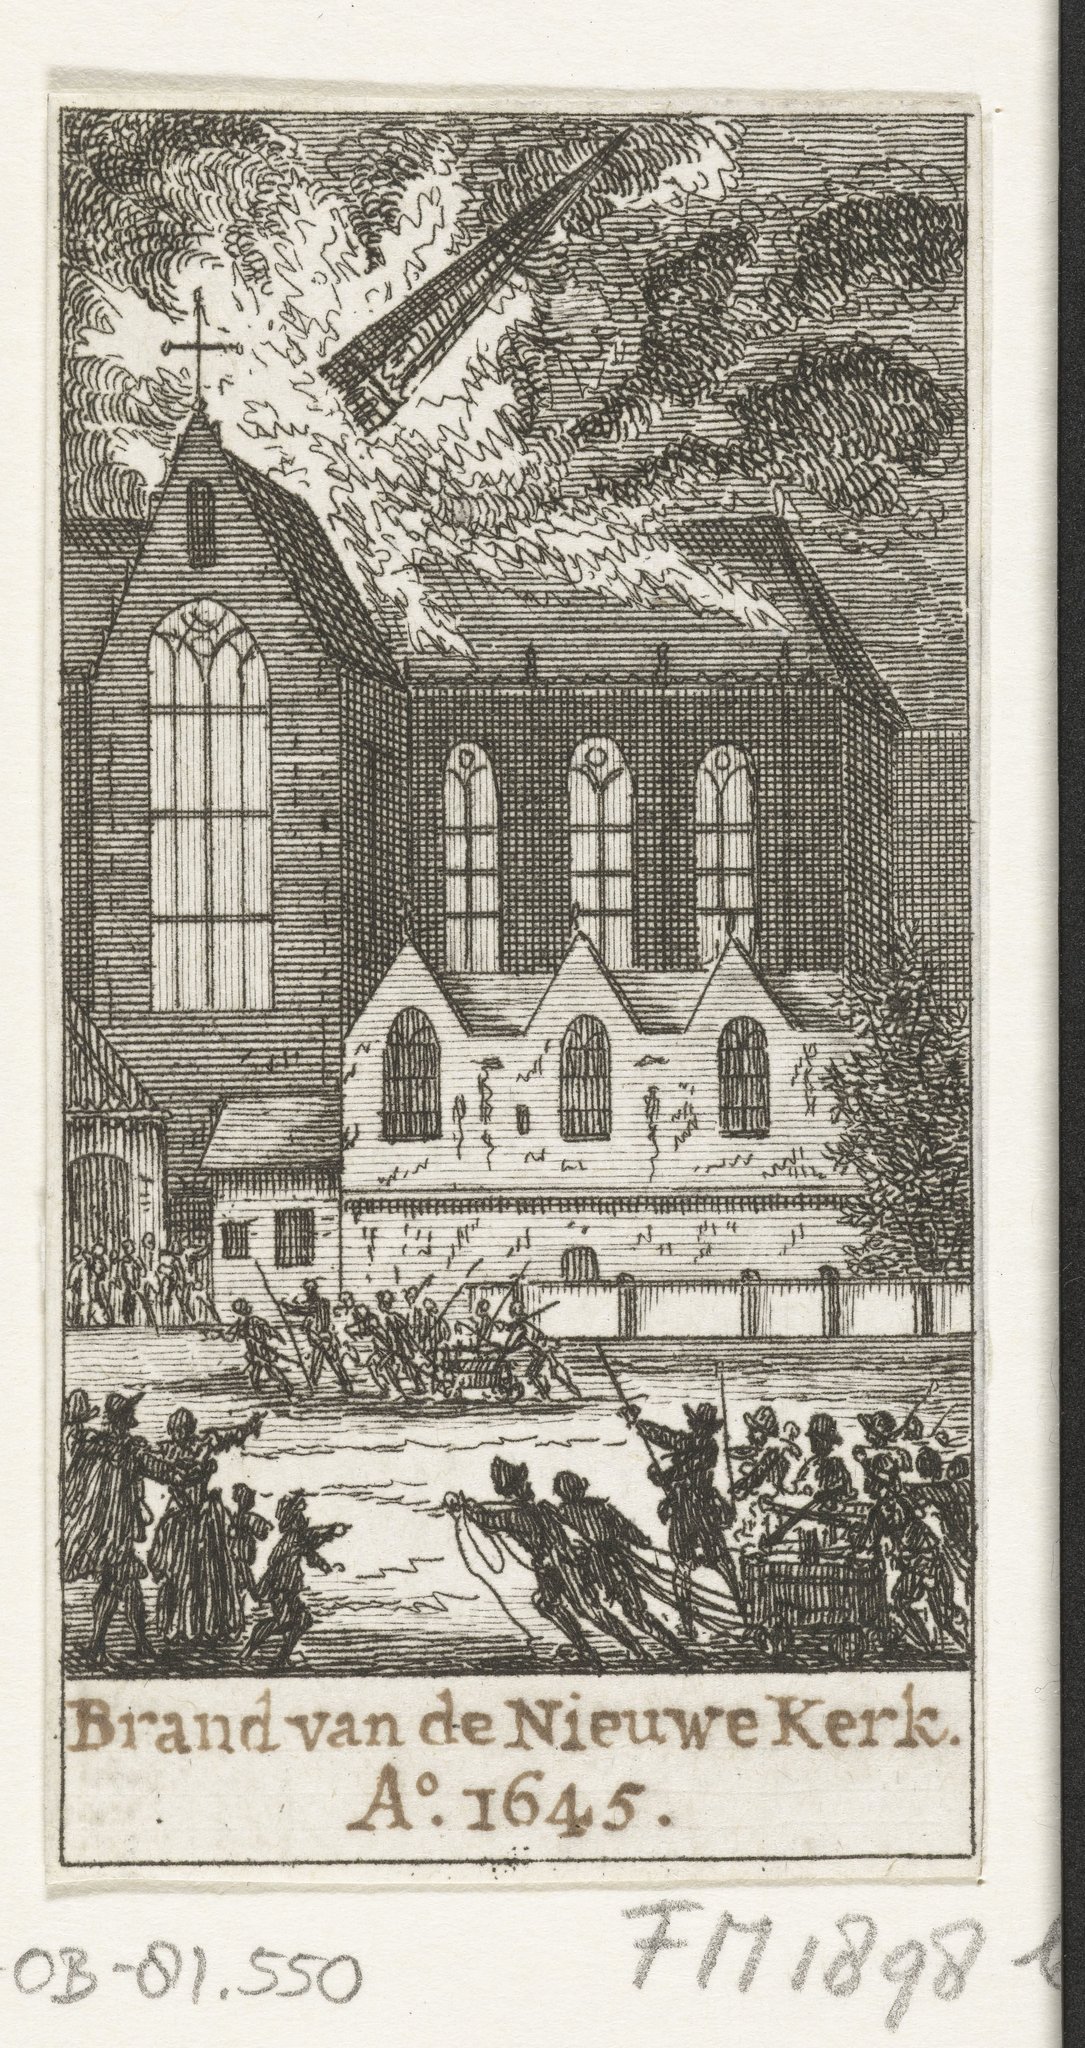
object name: history print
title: Brand in de Nieuwe Kerk te Amsterdam, 1645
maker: simon fokke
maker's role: draughtsman, print maker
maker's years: 1712-1784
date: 1722-1784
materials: paper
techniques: etching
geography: northern netherlands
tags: fire-fighting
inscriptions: inscription: ‘Brand van de Nieuwe Kerk. Ao. 1645’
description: Brand in de Nieuwe Kerk te Amsterdam, 11 januari 1645. De spits valt om, op de voorgrond komt de brandweer aangesneld.